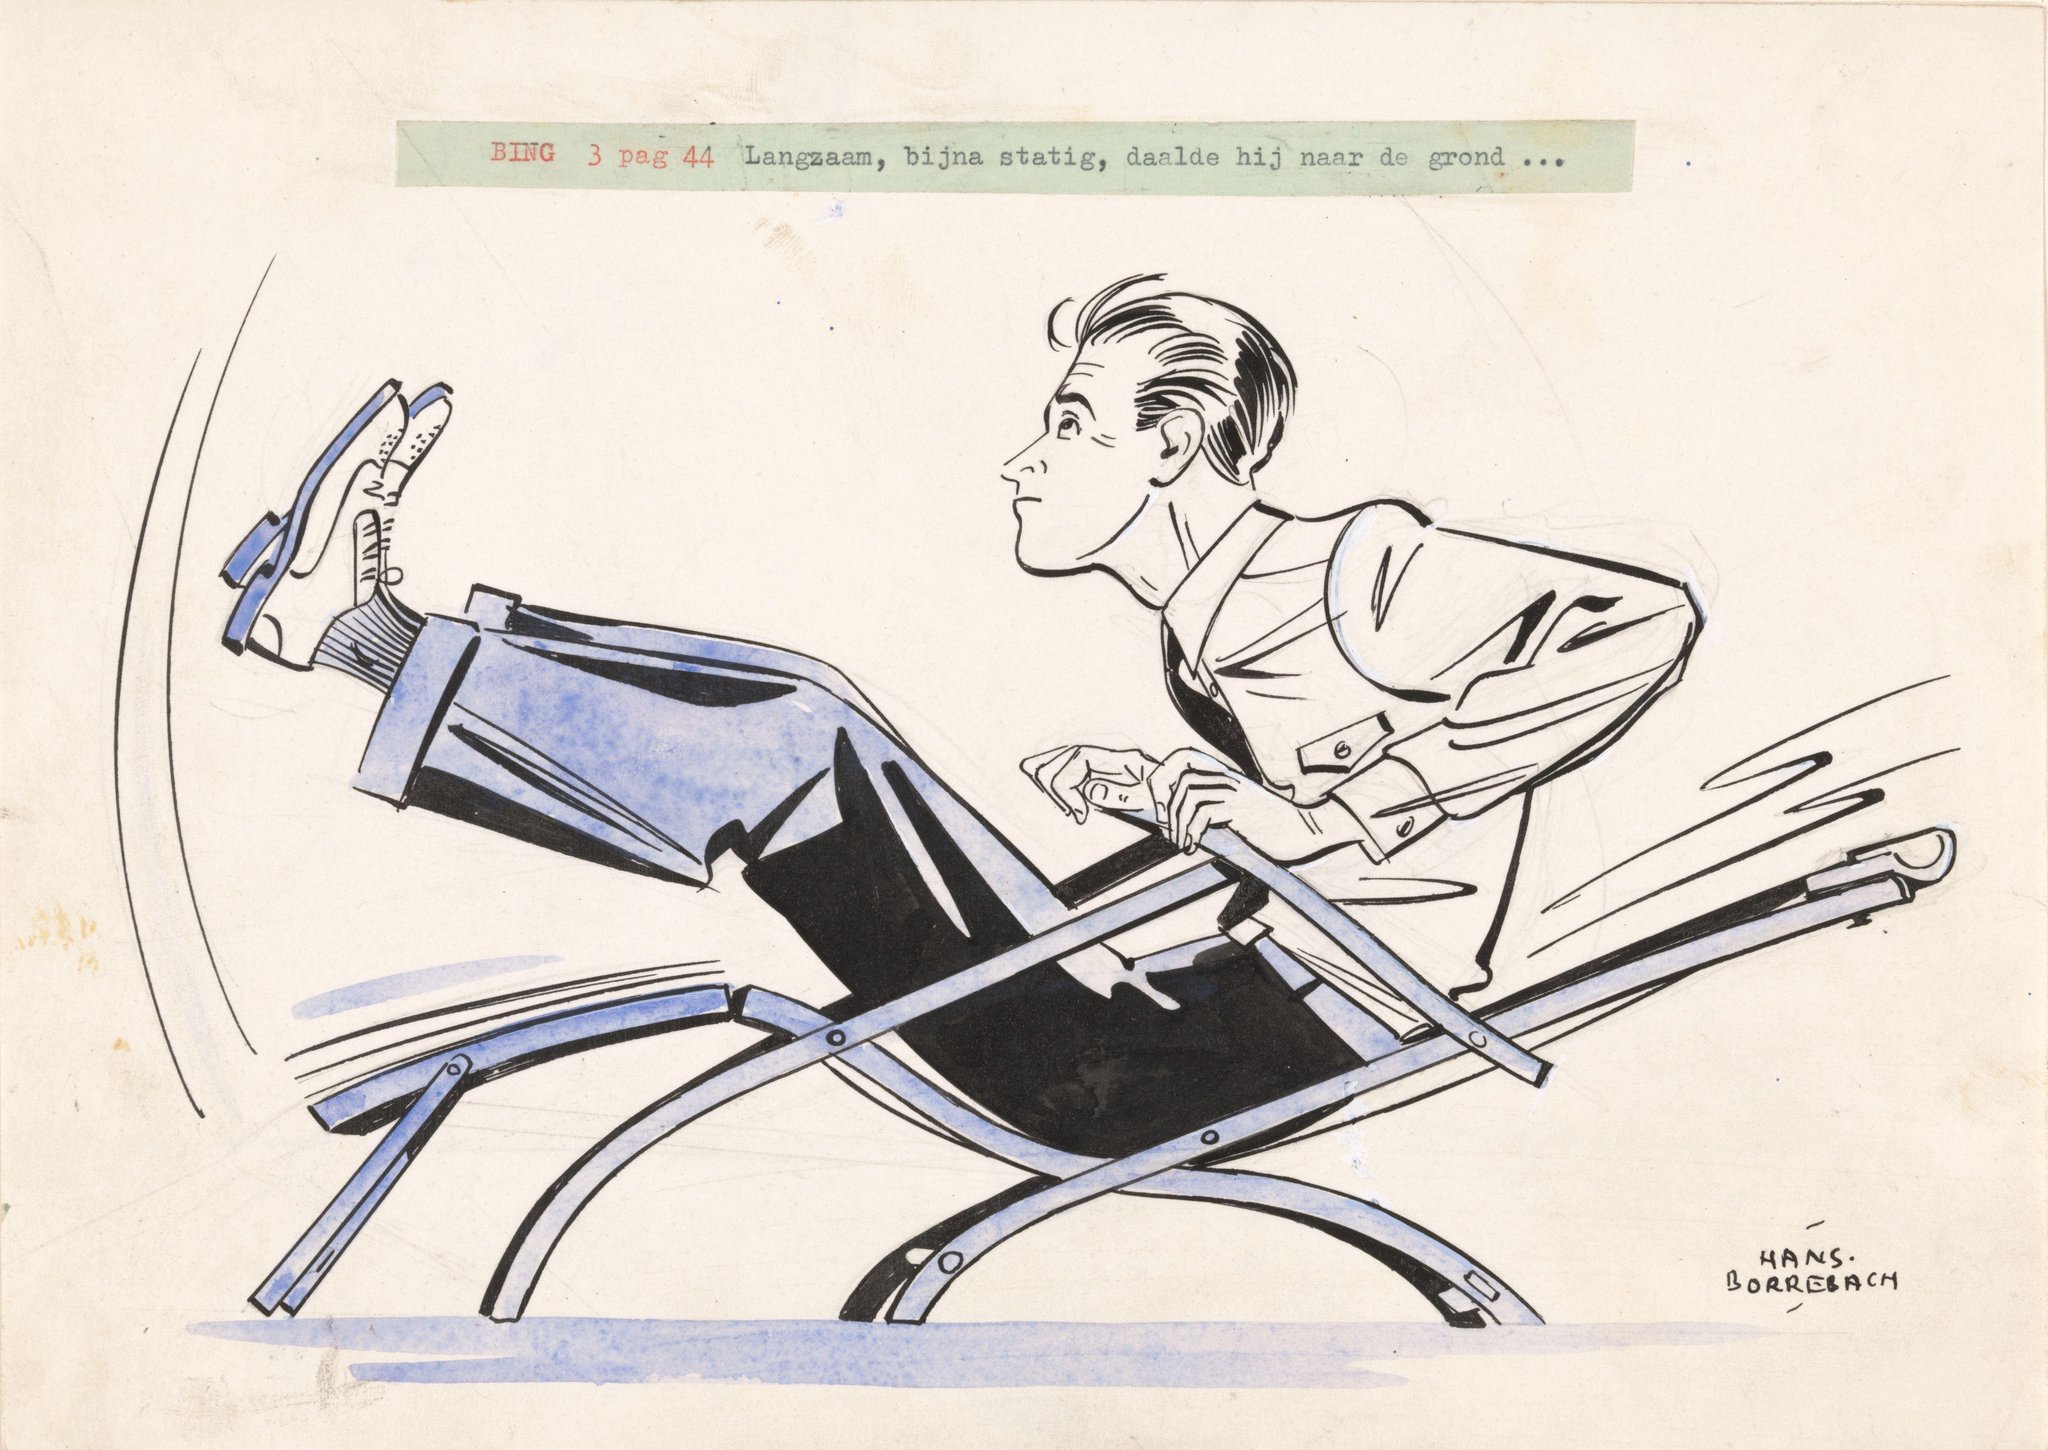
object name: boekillustratie ontwerp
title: Piet Bing valt achterover in een ligstoel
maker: hans borrebach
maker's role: draughtsman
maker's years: 1903-1991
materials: paint, ink, paper, pencil, watercolor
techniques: brush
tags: seating furniture, falling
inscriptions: collector's mark: Lugt 2228a, signature: ‘HANS./ BORREBACH’, number:, :, annotation: ‘BING 3 pag 44 Langzaam, bijna statig, daalde hij naar de grond ...’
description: Met de handen op de armleuningen en de voeten in de lucht valt Piet Bing achterover in een ligstoel.